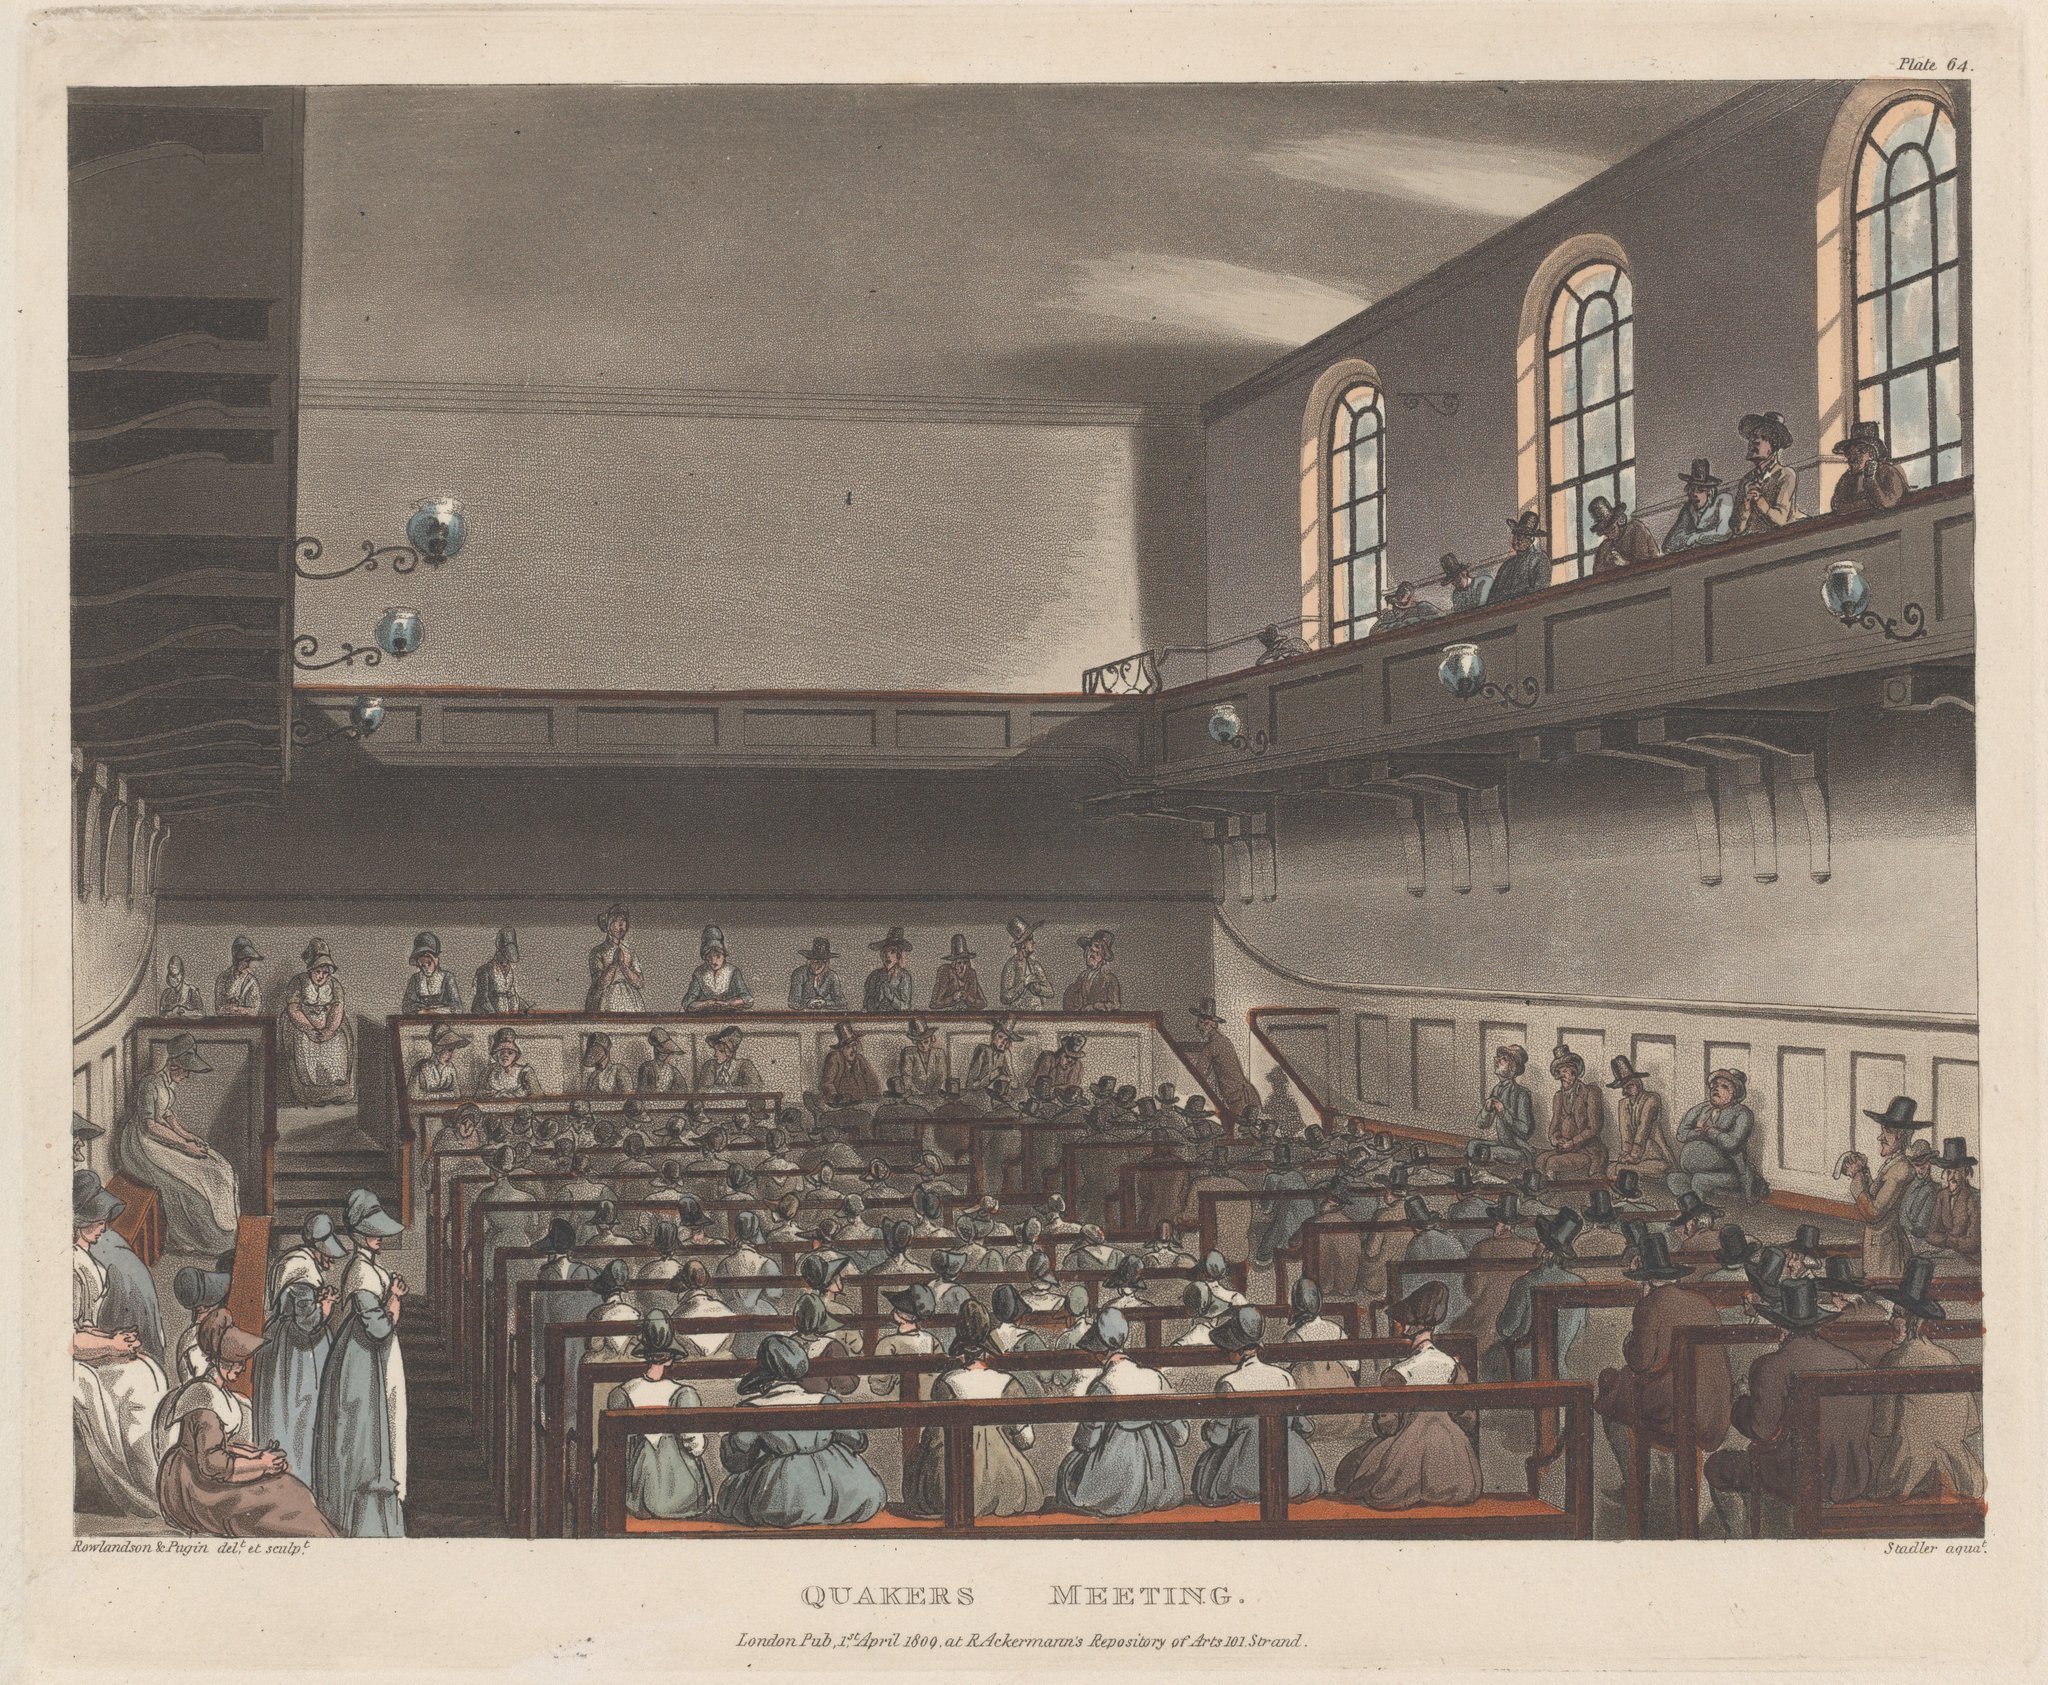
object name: print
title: Quakers Meeting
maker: thomas rowlandson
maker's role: artist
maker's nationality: british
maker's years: 1757-1827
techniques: aquatint, etching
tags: interiors